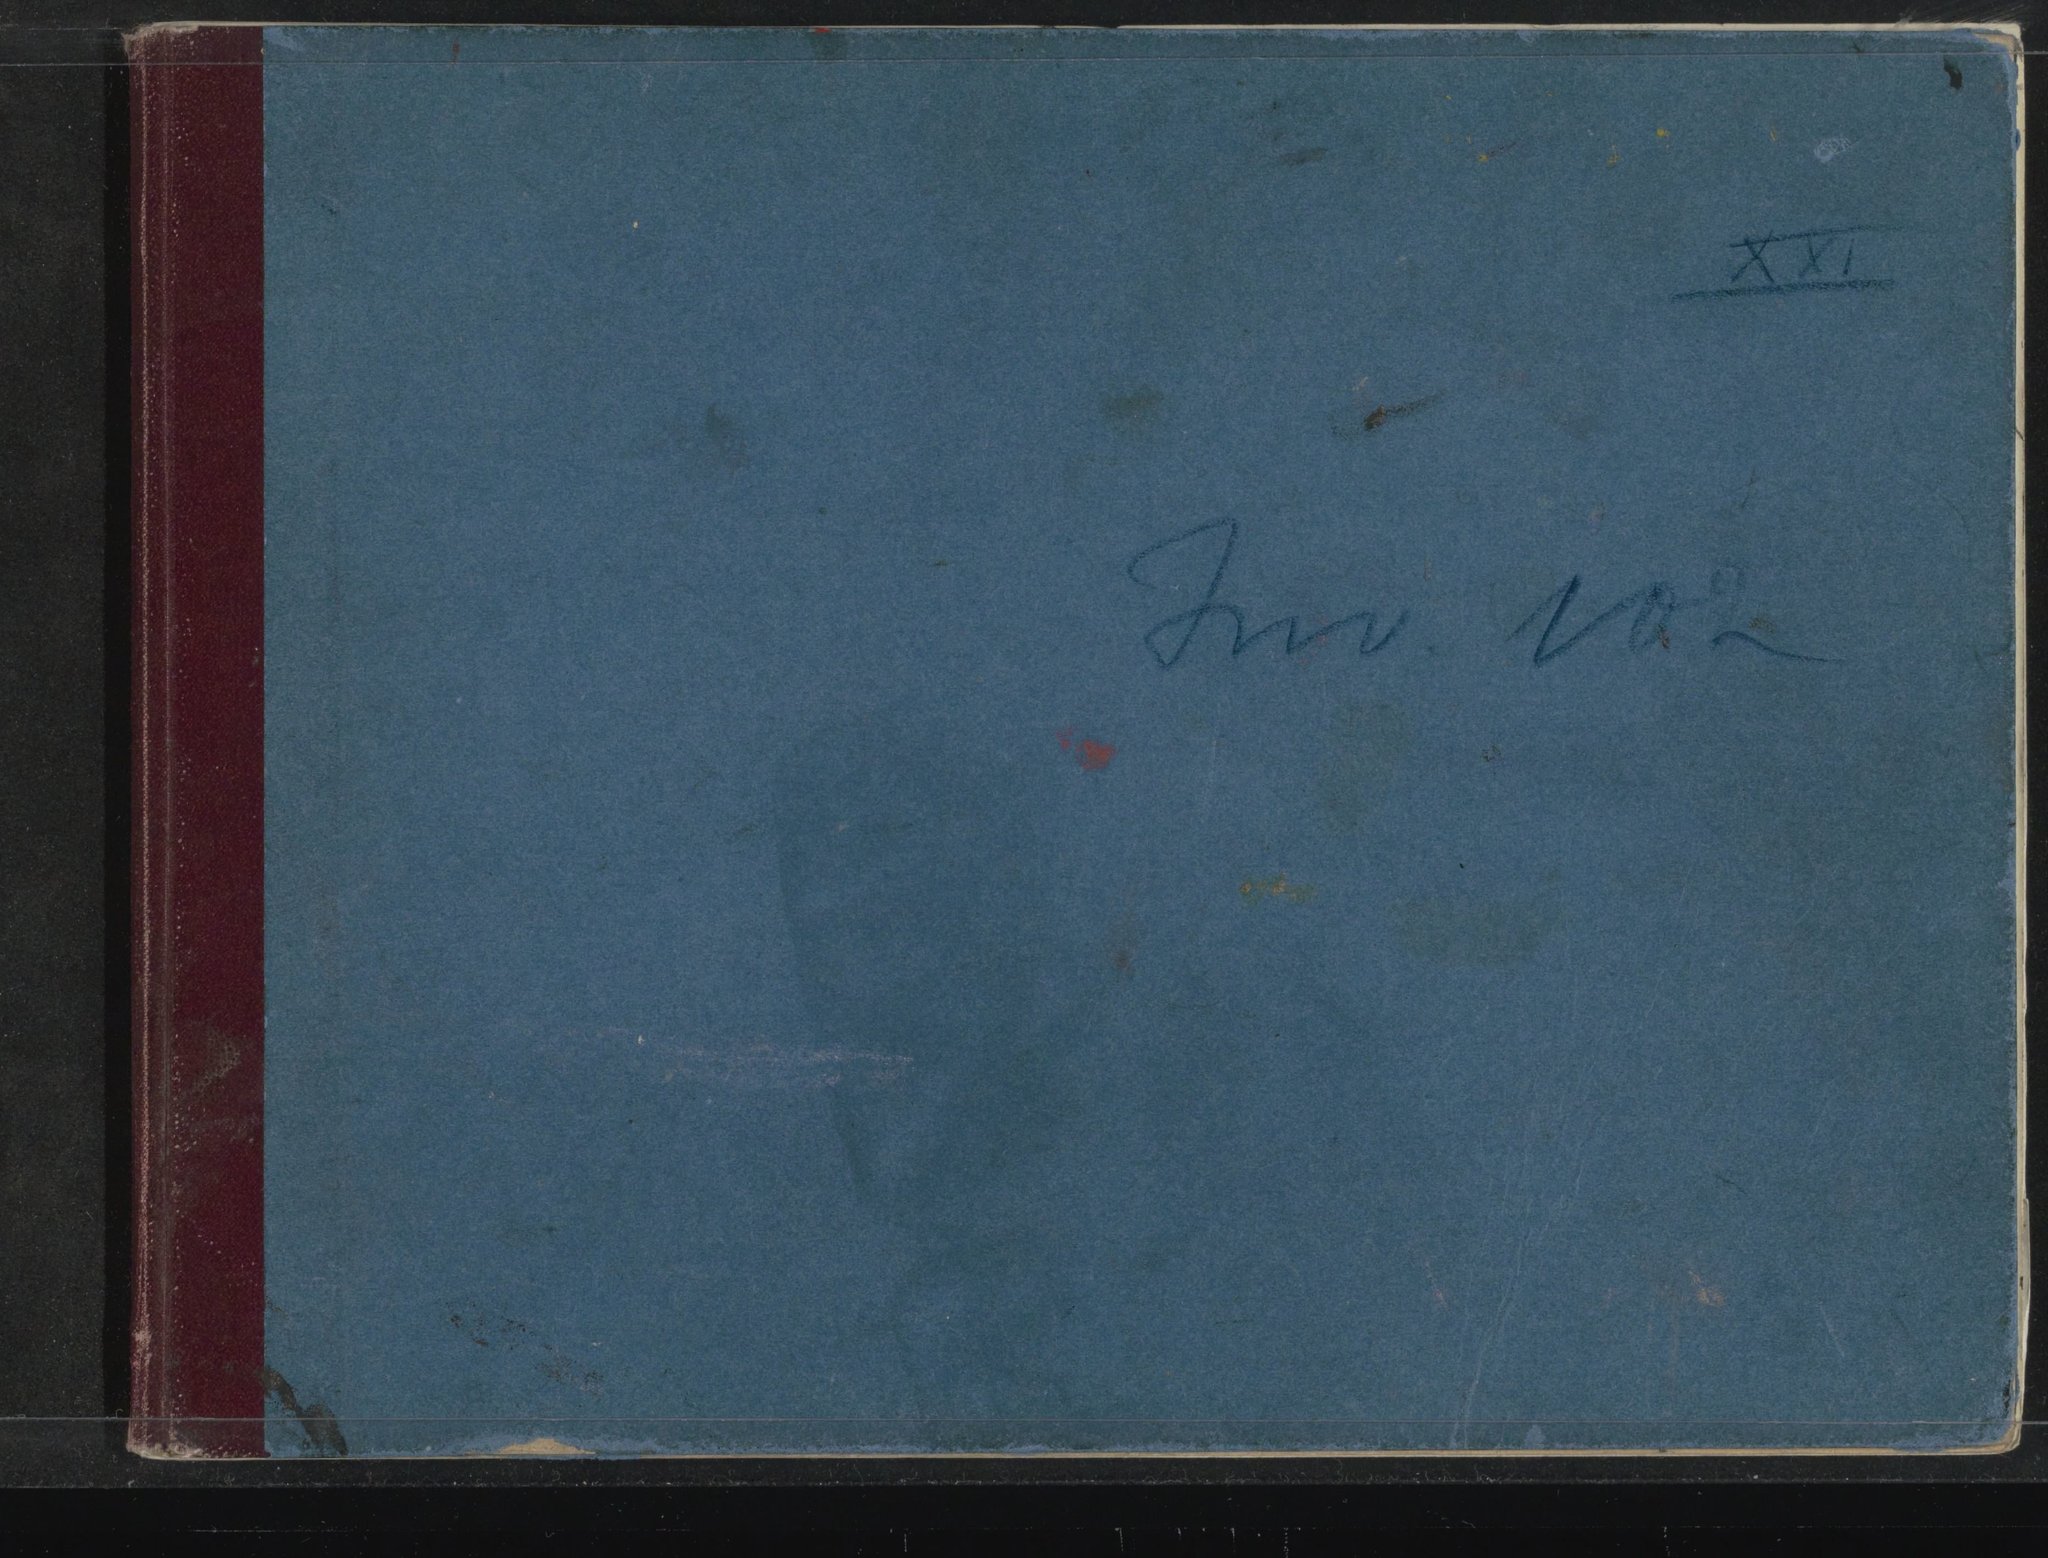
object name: sketchbook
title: Schetsboek XXI met 19 bladen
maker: isaac israels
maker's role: draughtsman, painter, print maker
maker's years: 1865-1934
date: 1875-1934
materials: cardboard, chalk, ink, linen, paper, pencil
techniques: pen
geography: the hague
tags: postures of the human figure, in or beside the water (on the beach)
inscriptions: collector's mark: Lugt 2228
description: Op de kaft figuurstudies. Schetsboek nr. XXI bestaande uit 19 bladen met vrouwen, strandscènes en portretten.